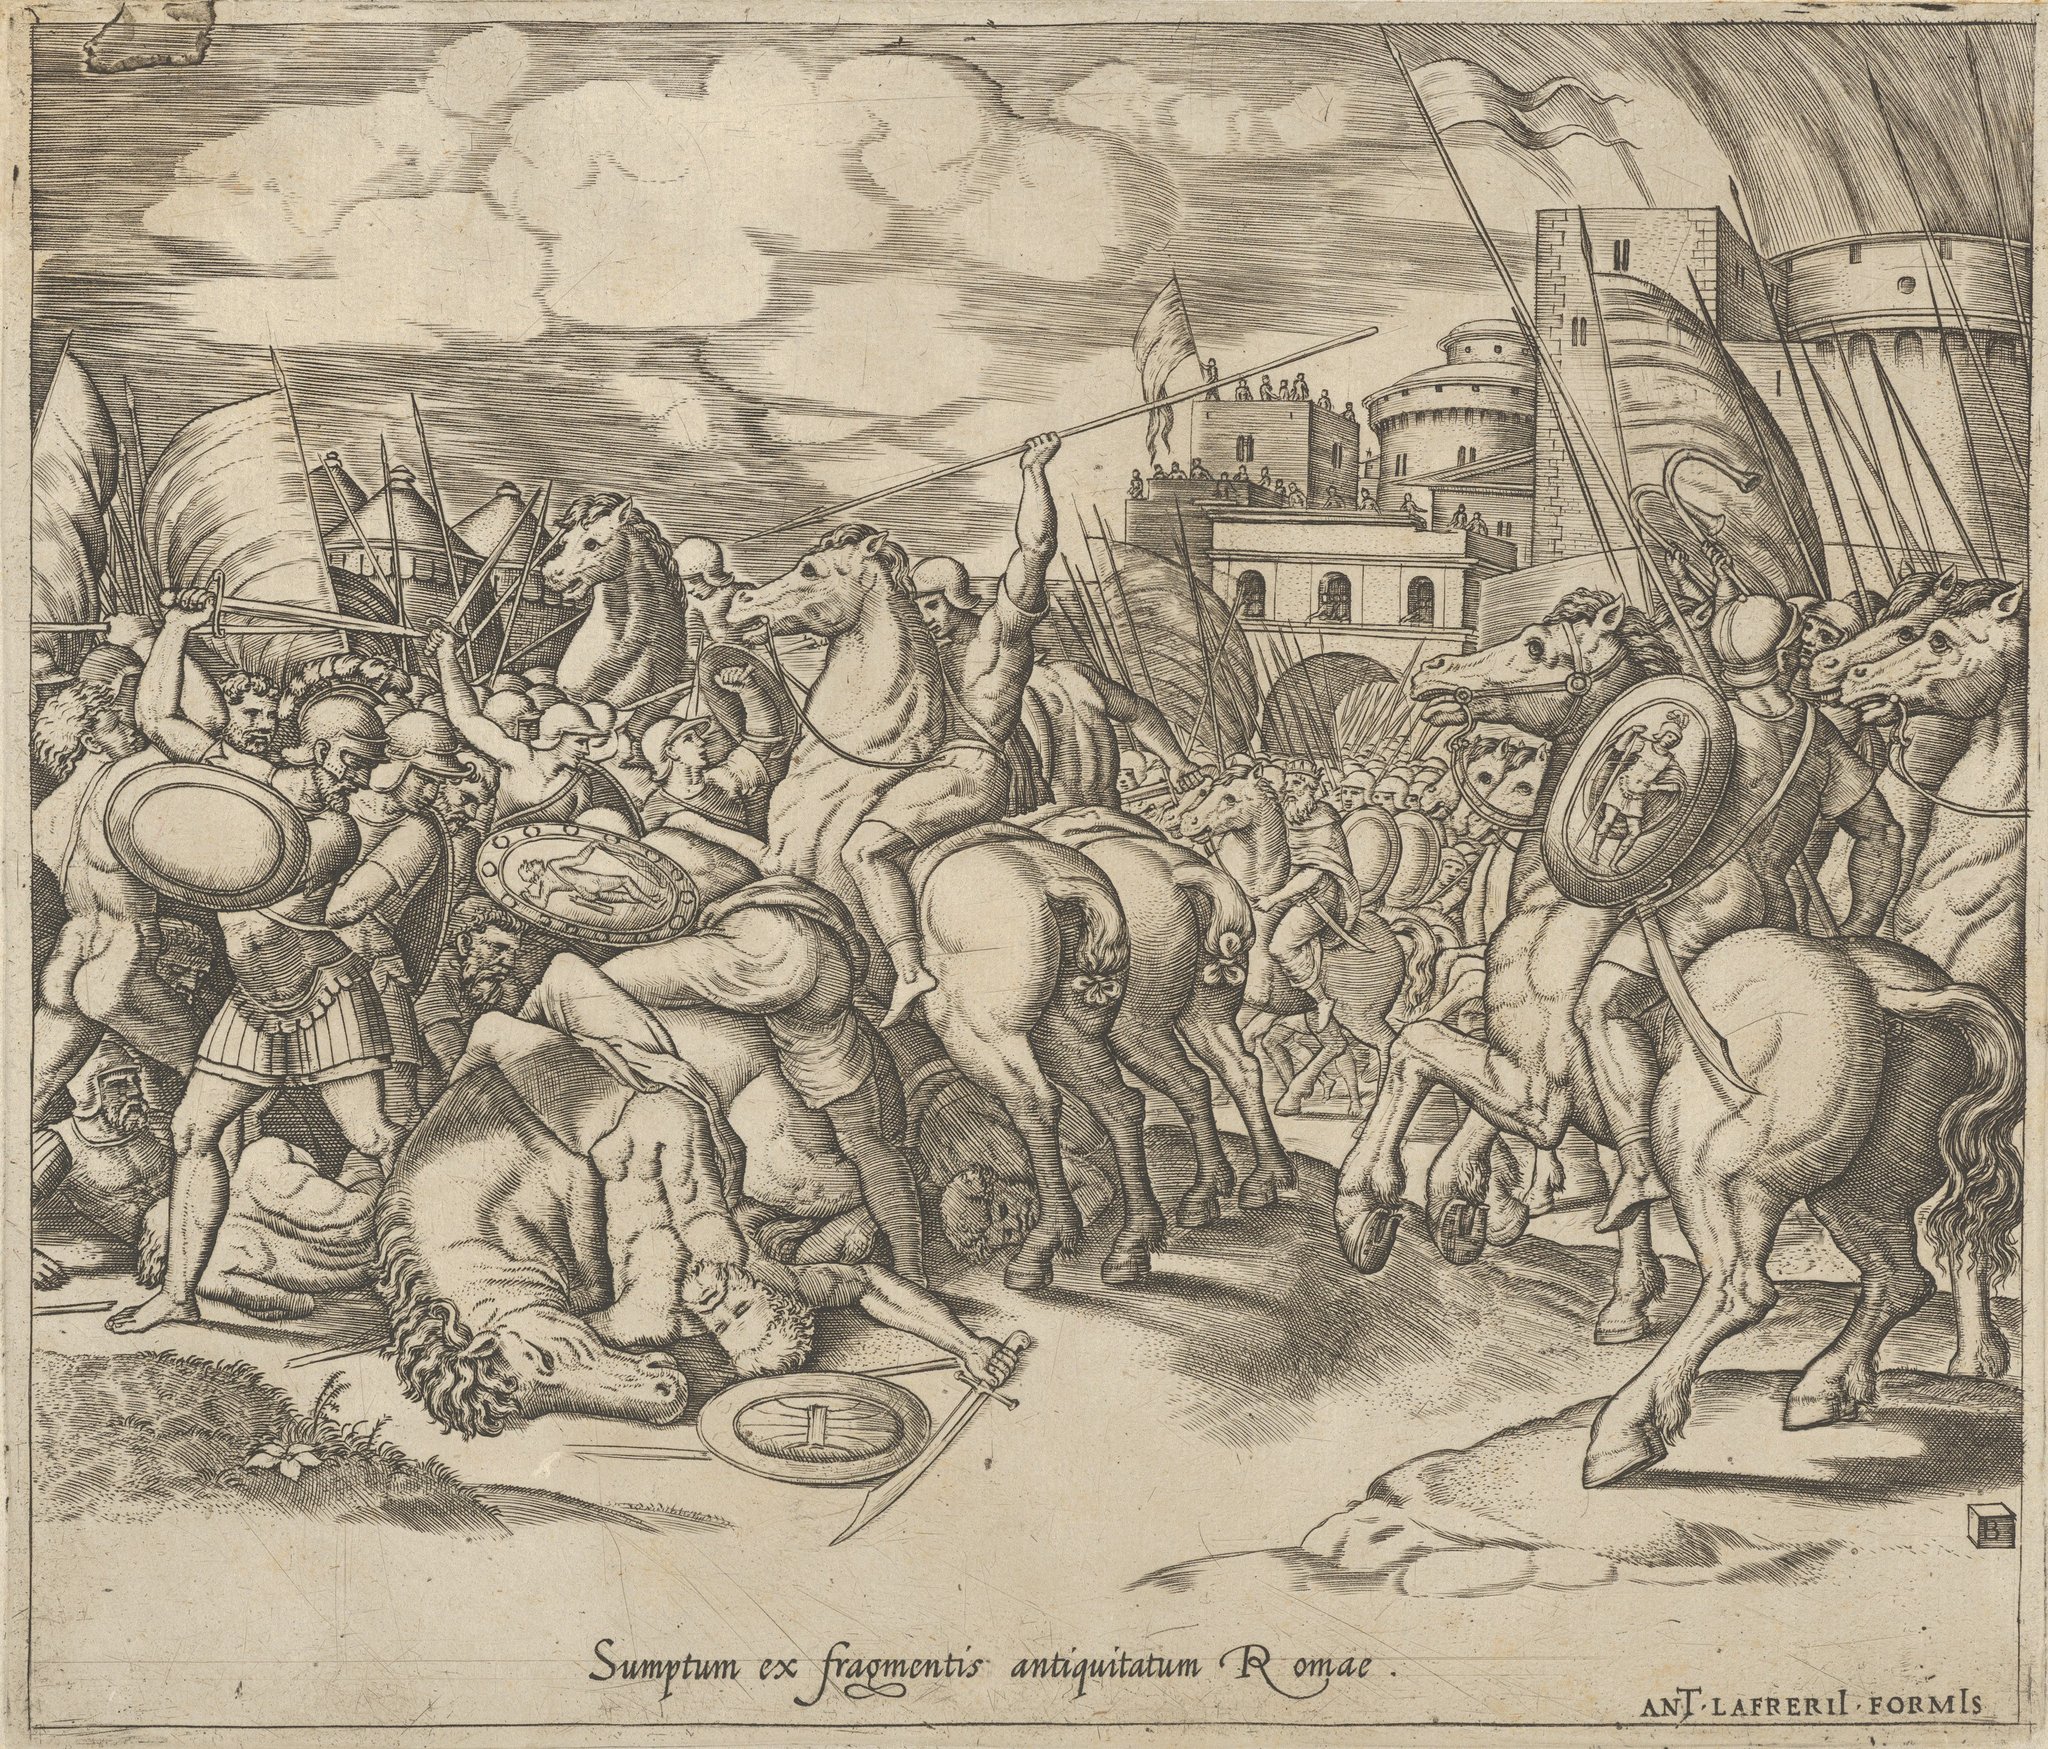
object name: print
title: The Victory of Scipio, from "Speculum Romanae Magnificentiae"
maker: master of the die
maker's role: artist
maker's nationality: italian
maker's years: 1525-1560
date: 1501-1600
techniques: engraving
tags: fortification,battles,soldiers,weapons,horses